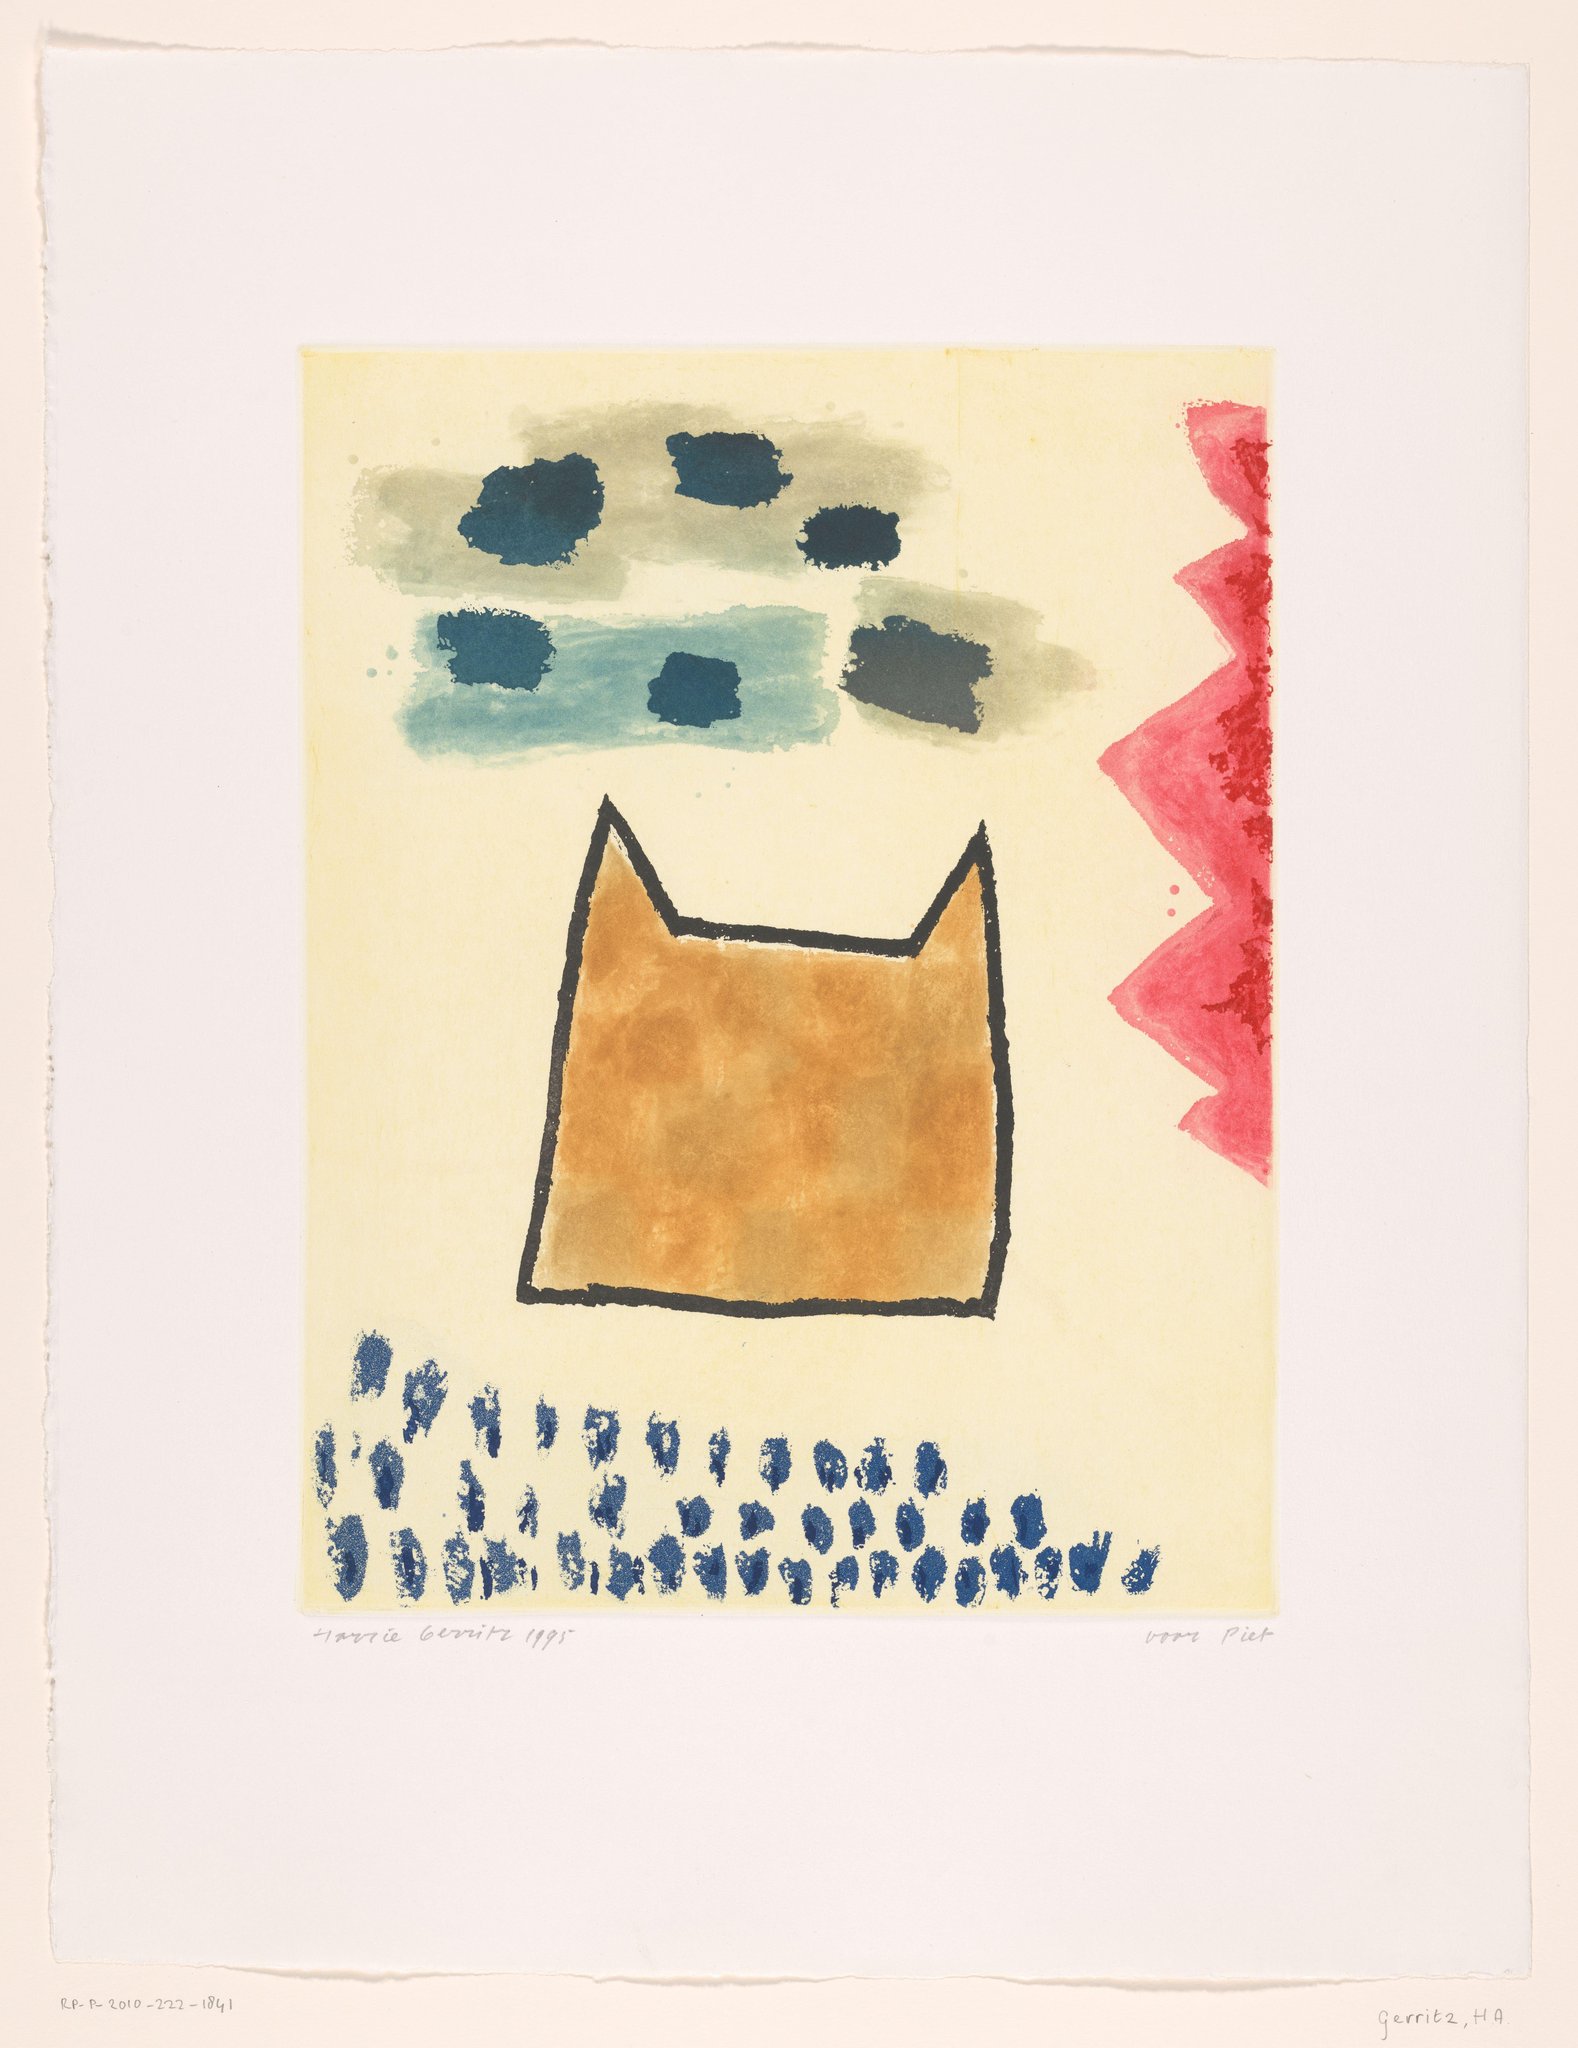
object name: print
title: Abstracte compositie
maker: harrie a. gerritz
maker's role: draughtsman, painter, print maker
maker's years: 1940-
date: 1995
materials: paper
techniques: aquatint, intaglio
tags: abstract, non-representational art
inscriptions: inscription: ‘PC’, dedication: ‘voor Piet’, watermark, collector's mark: Lugt 2228